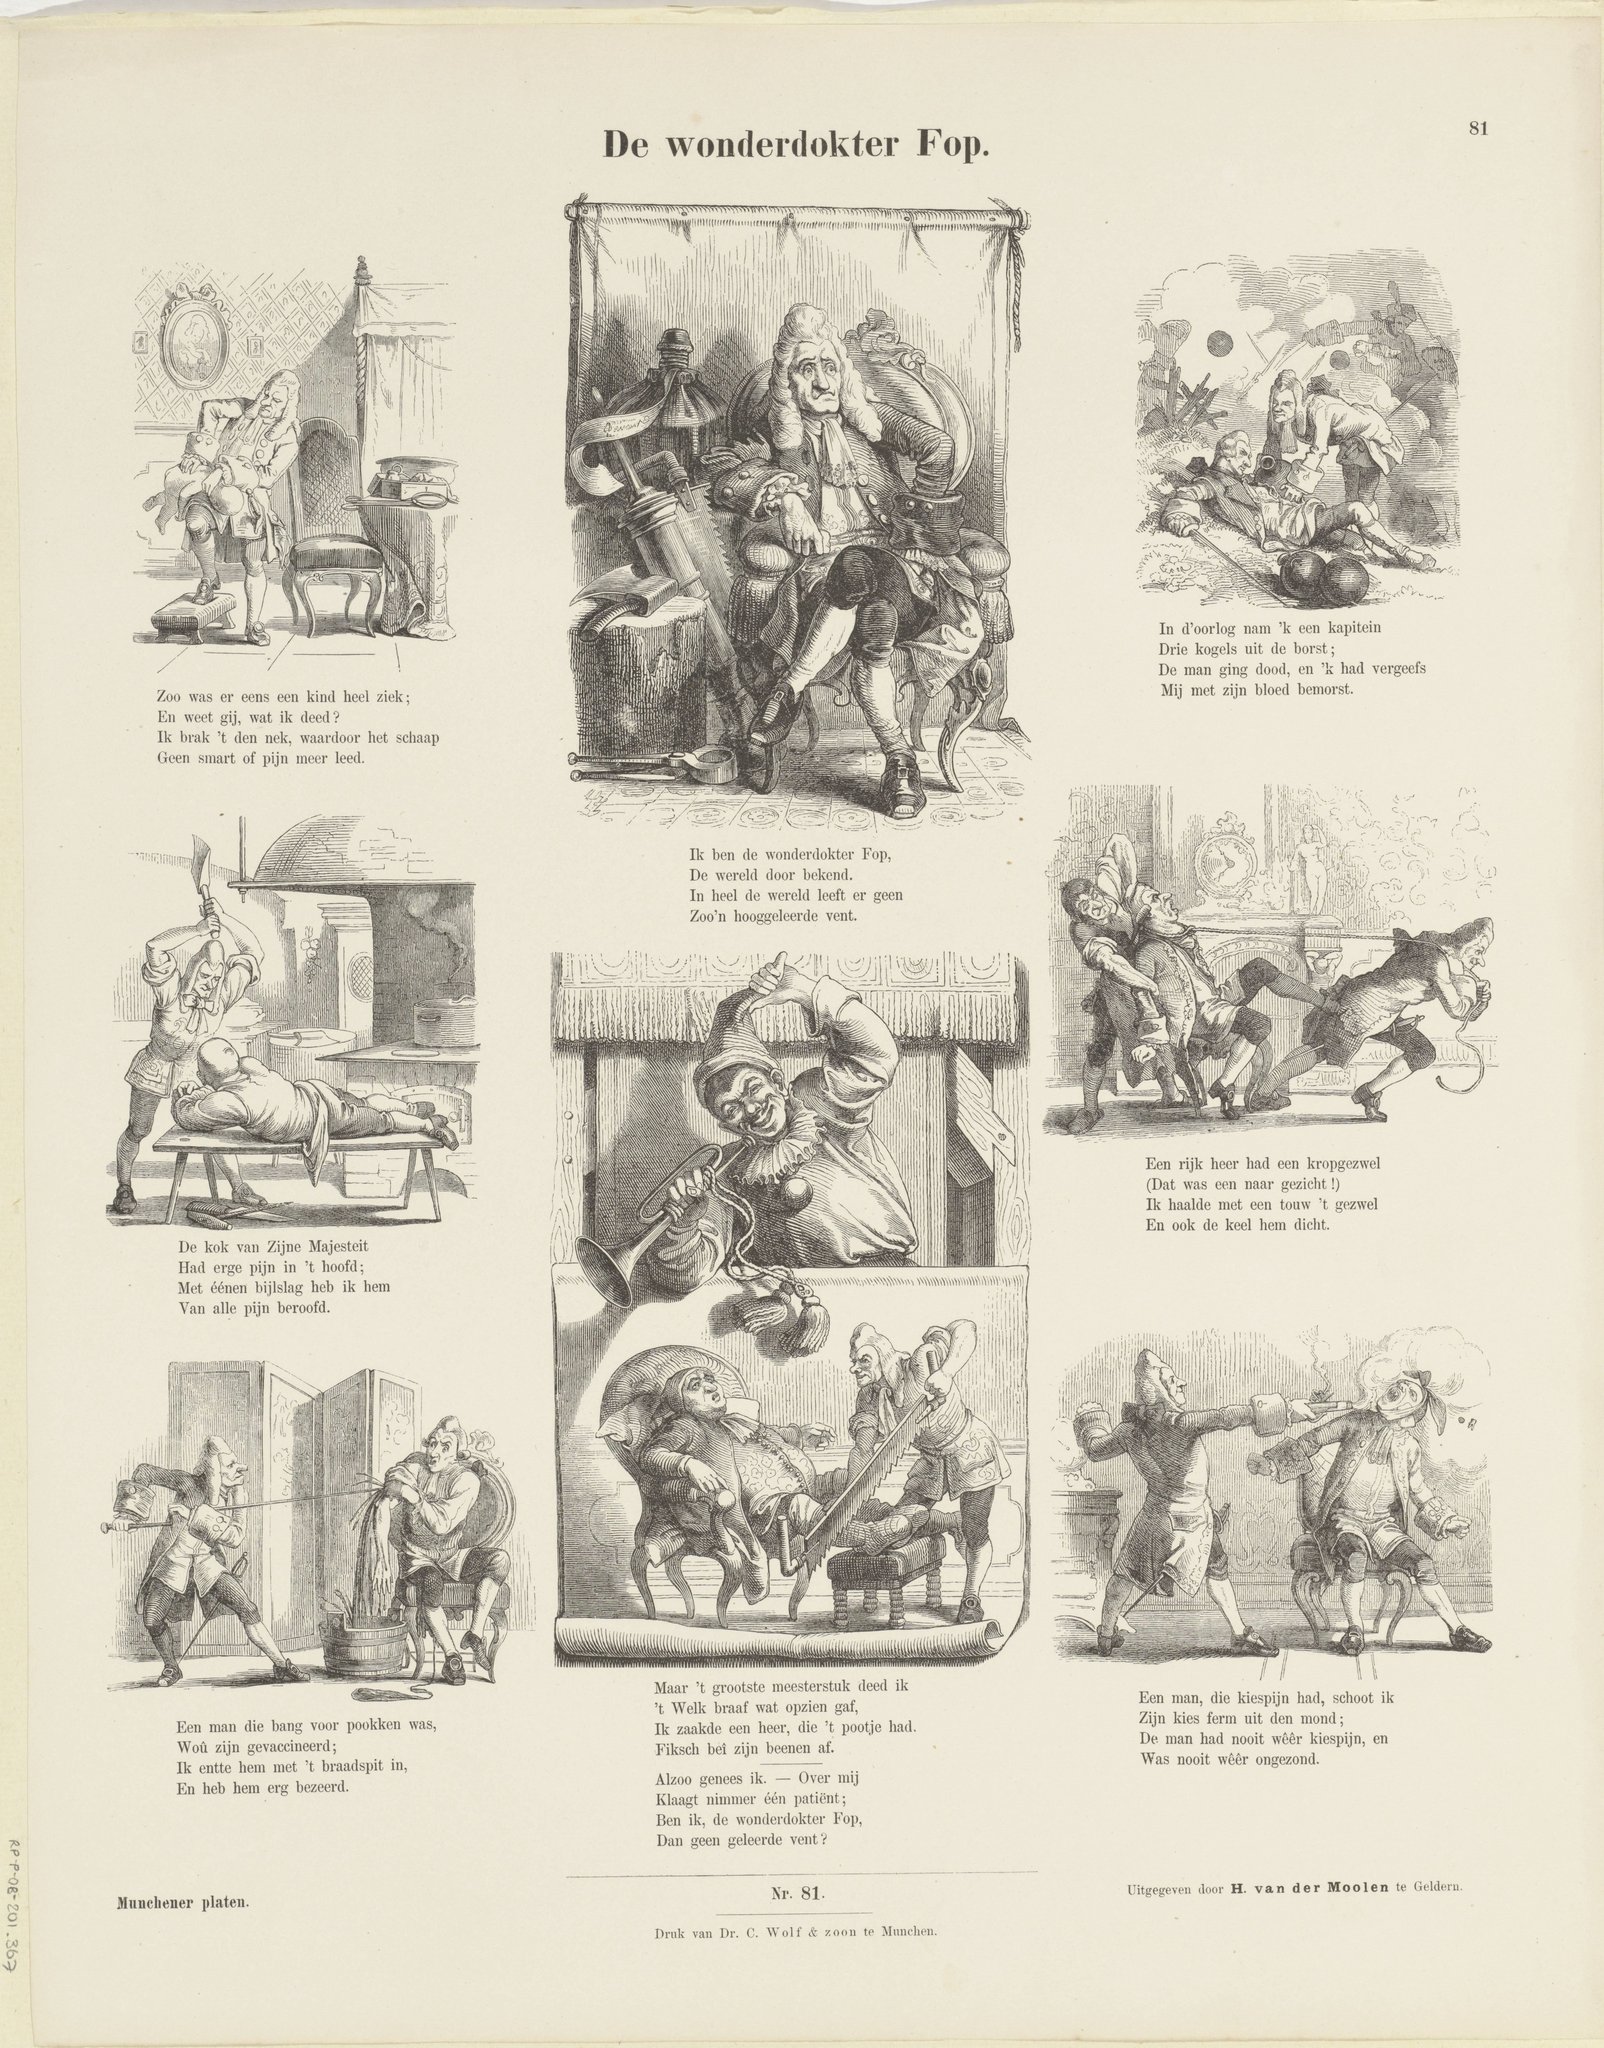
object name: print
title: De wonderdokter Fop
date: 1843-1920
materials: paper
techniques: letterpress printing, engraving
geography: geldern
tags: quack, charlatan, mountebank, 'saltimbanco', physician, doctor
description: Blad met 8 voorstellingen over de radicale ingrepen van dokter Fop waar niemand niemand beter van wordt. Onder elke afbeelding een versje. Genummerd midden onder: Nro. 81. Genummerd rechtsboven: 81.